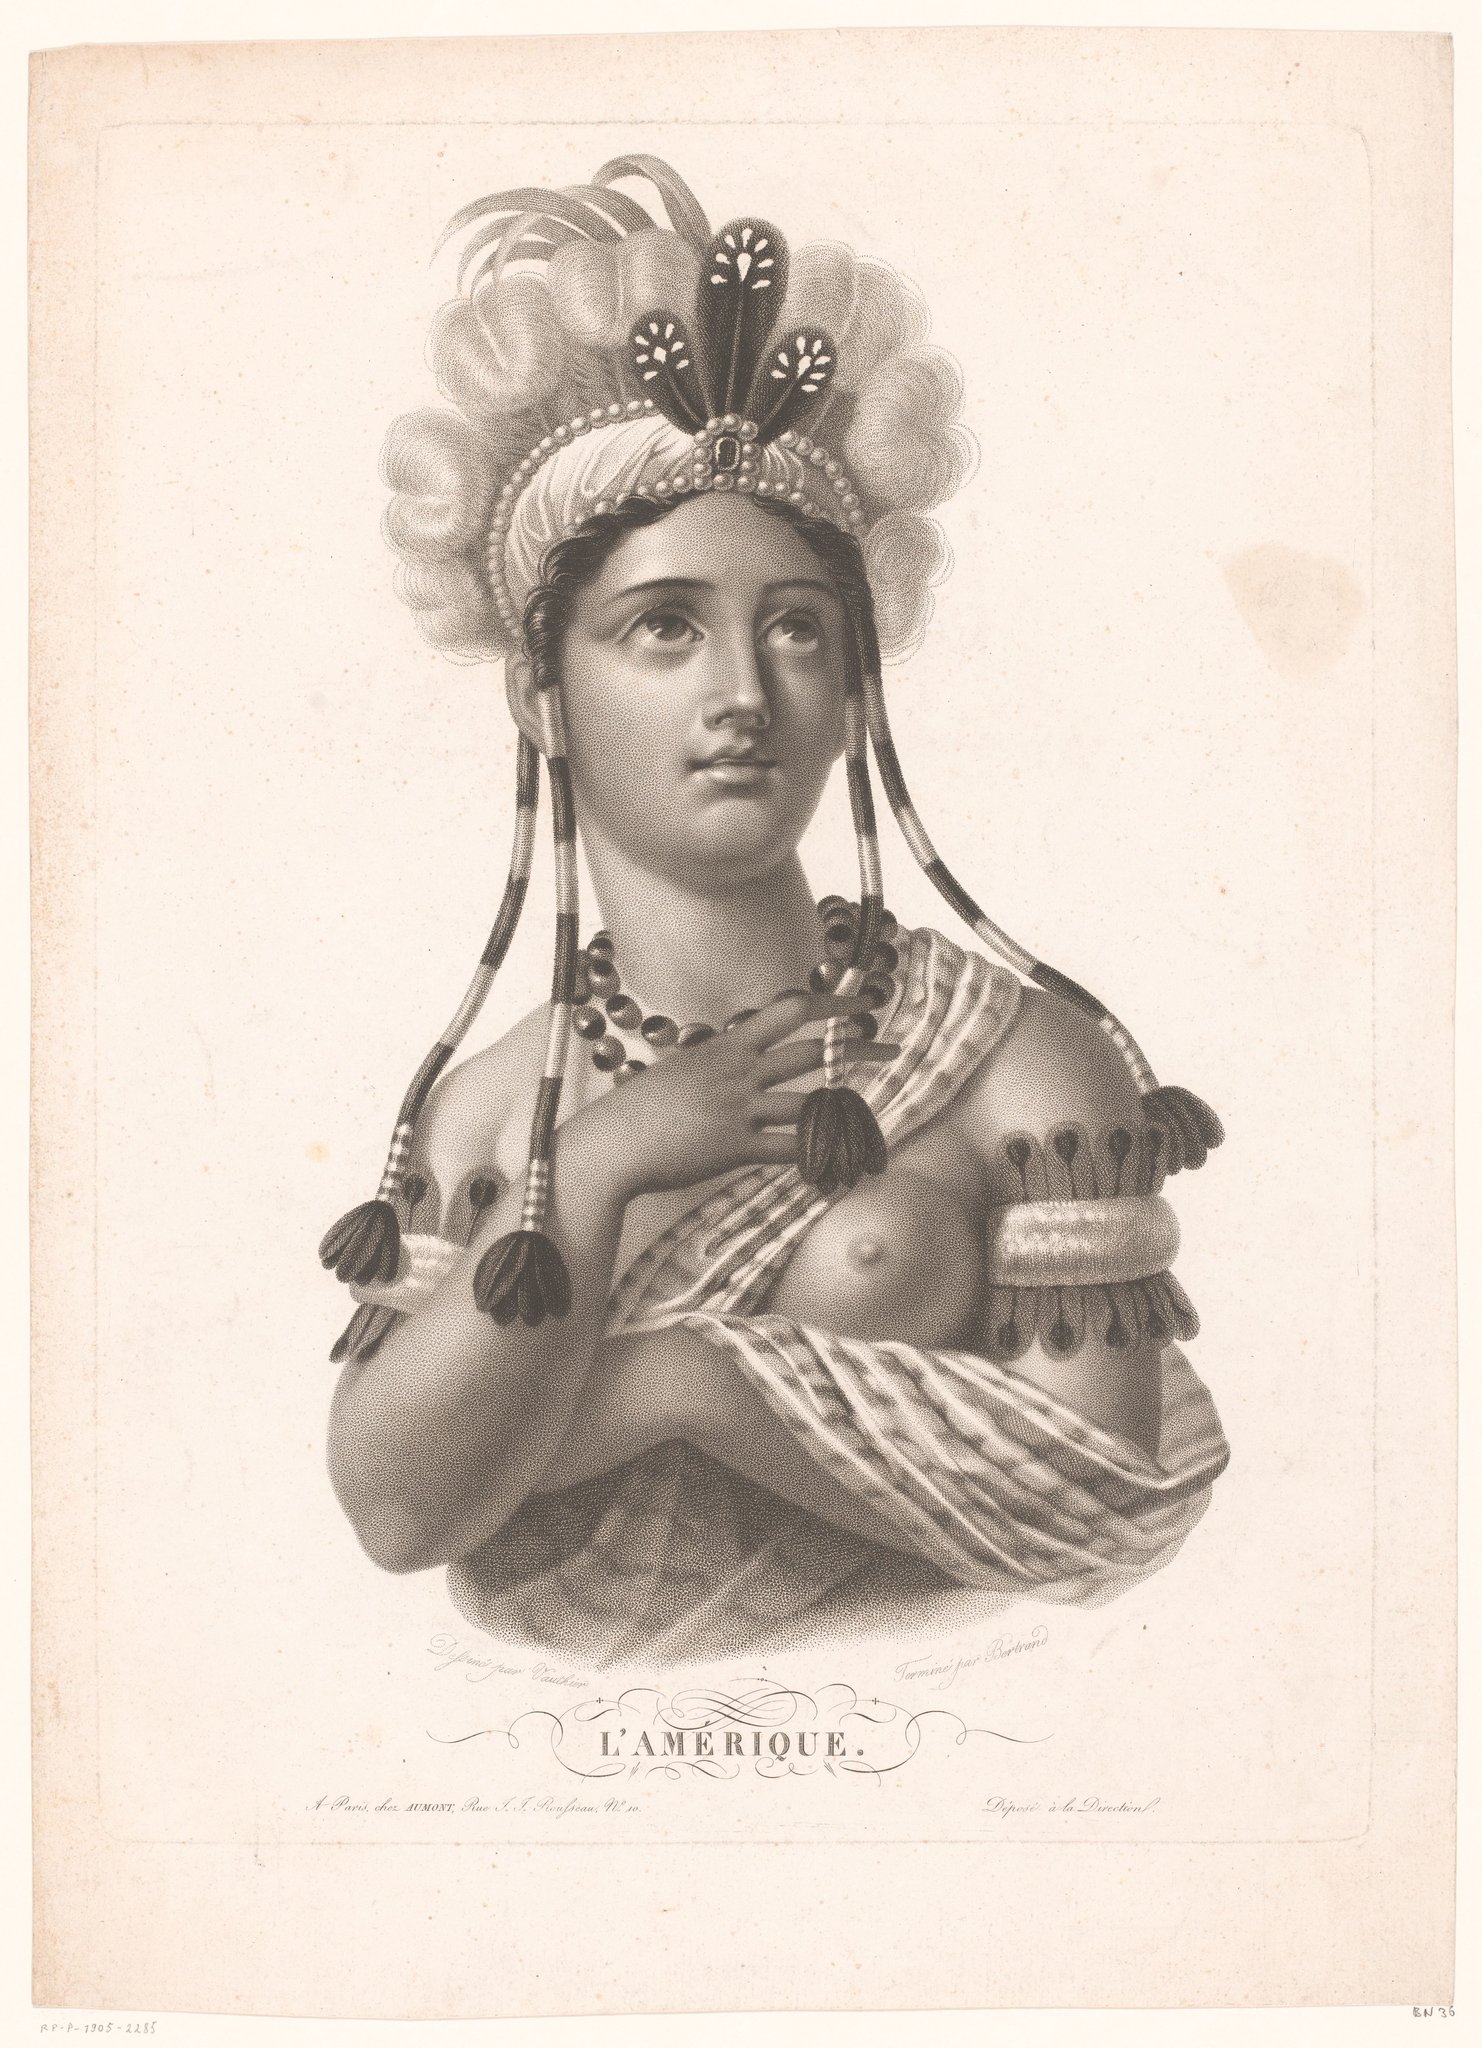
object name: print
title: Vier werelddelen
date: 1795-1852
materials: paper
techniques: stippling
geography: france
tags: america represented allegorically; 'america' (ripa)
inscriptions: collector's mark: Lugt 2228